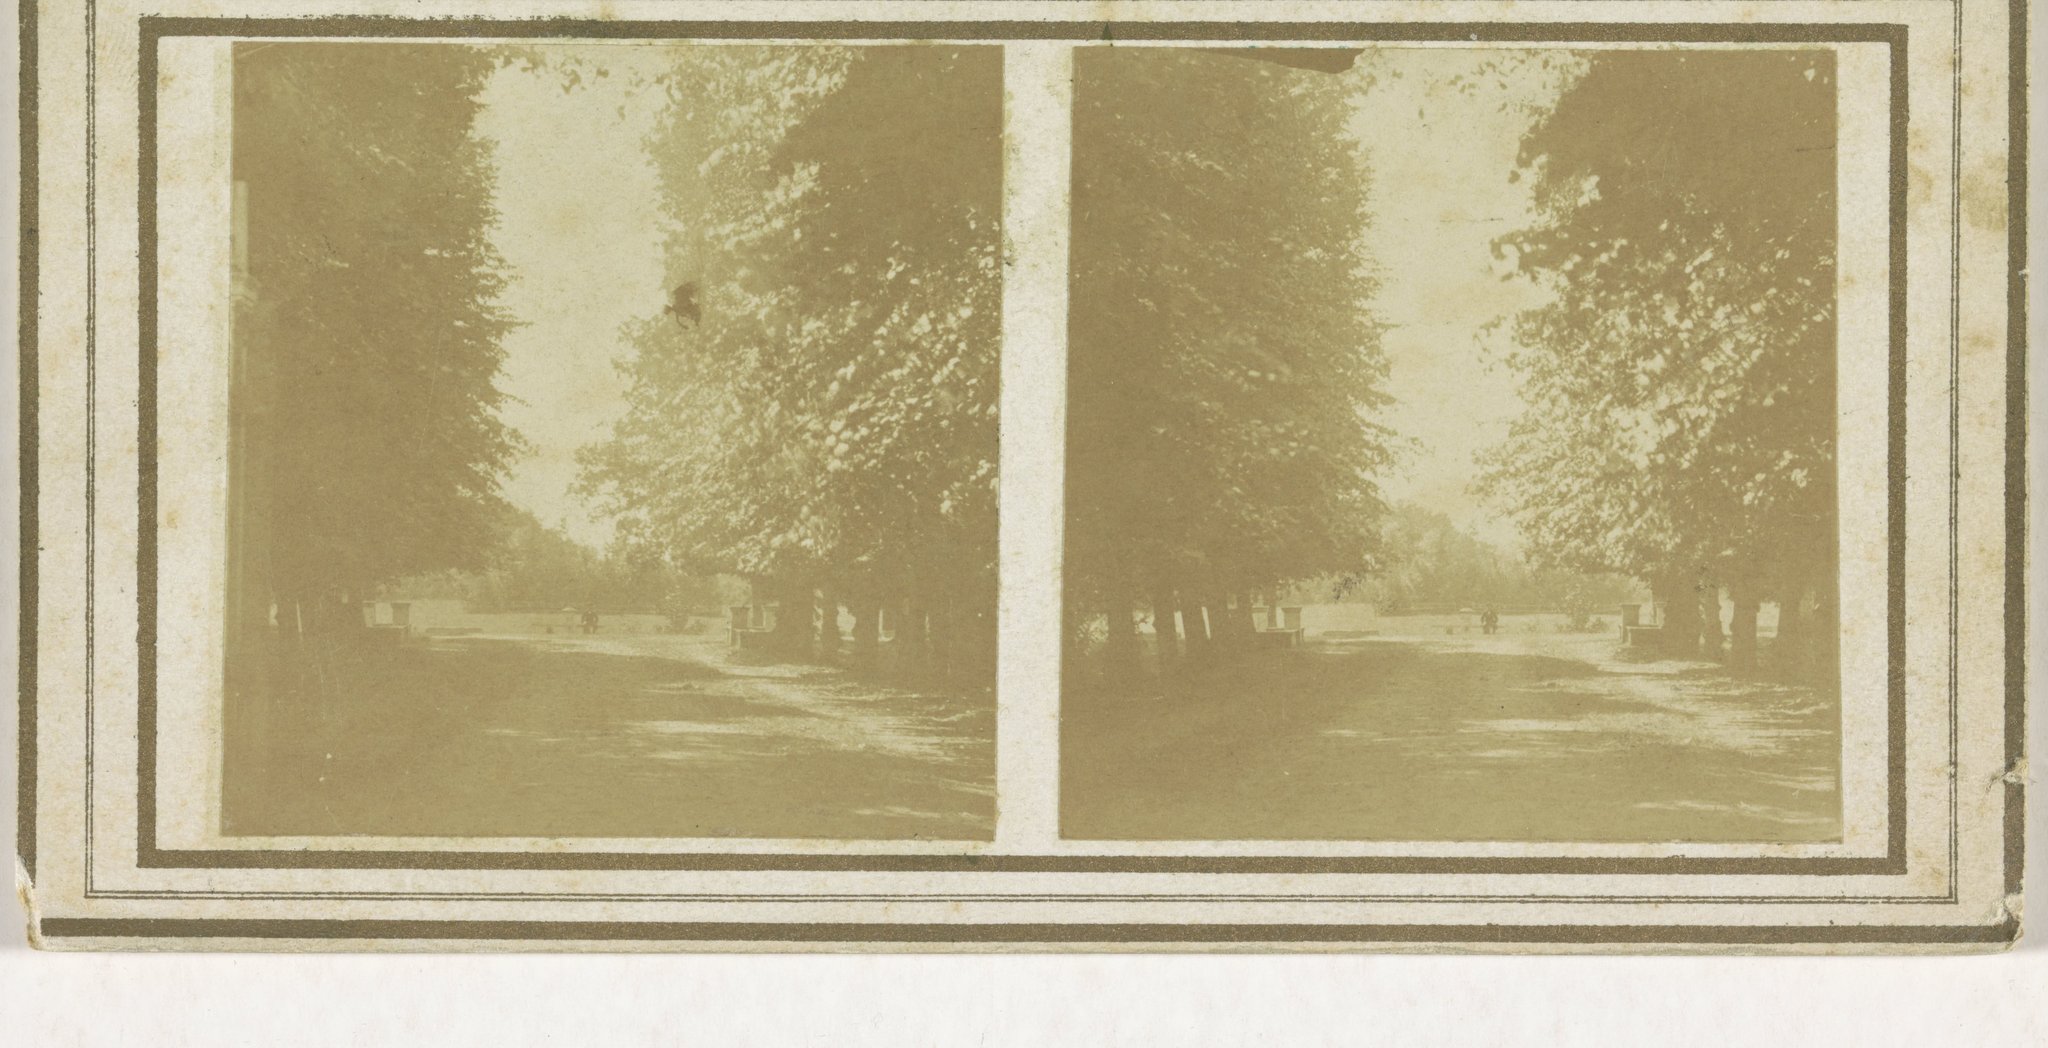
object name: stereograph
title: Laan vóór het Weldam te Goor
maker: Anonymous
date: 1856-1922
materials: cardboard, paper, photographic support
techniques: albumen print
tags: goor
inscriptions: inscription: ‘N.° 3.’, name: ‘H. Ameschot.’, title: ‘Laan vóór het Weldam te Goor (Overijssel.)’